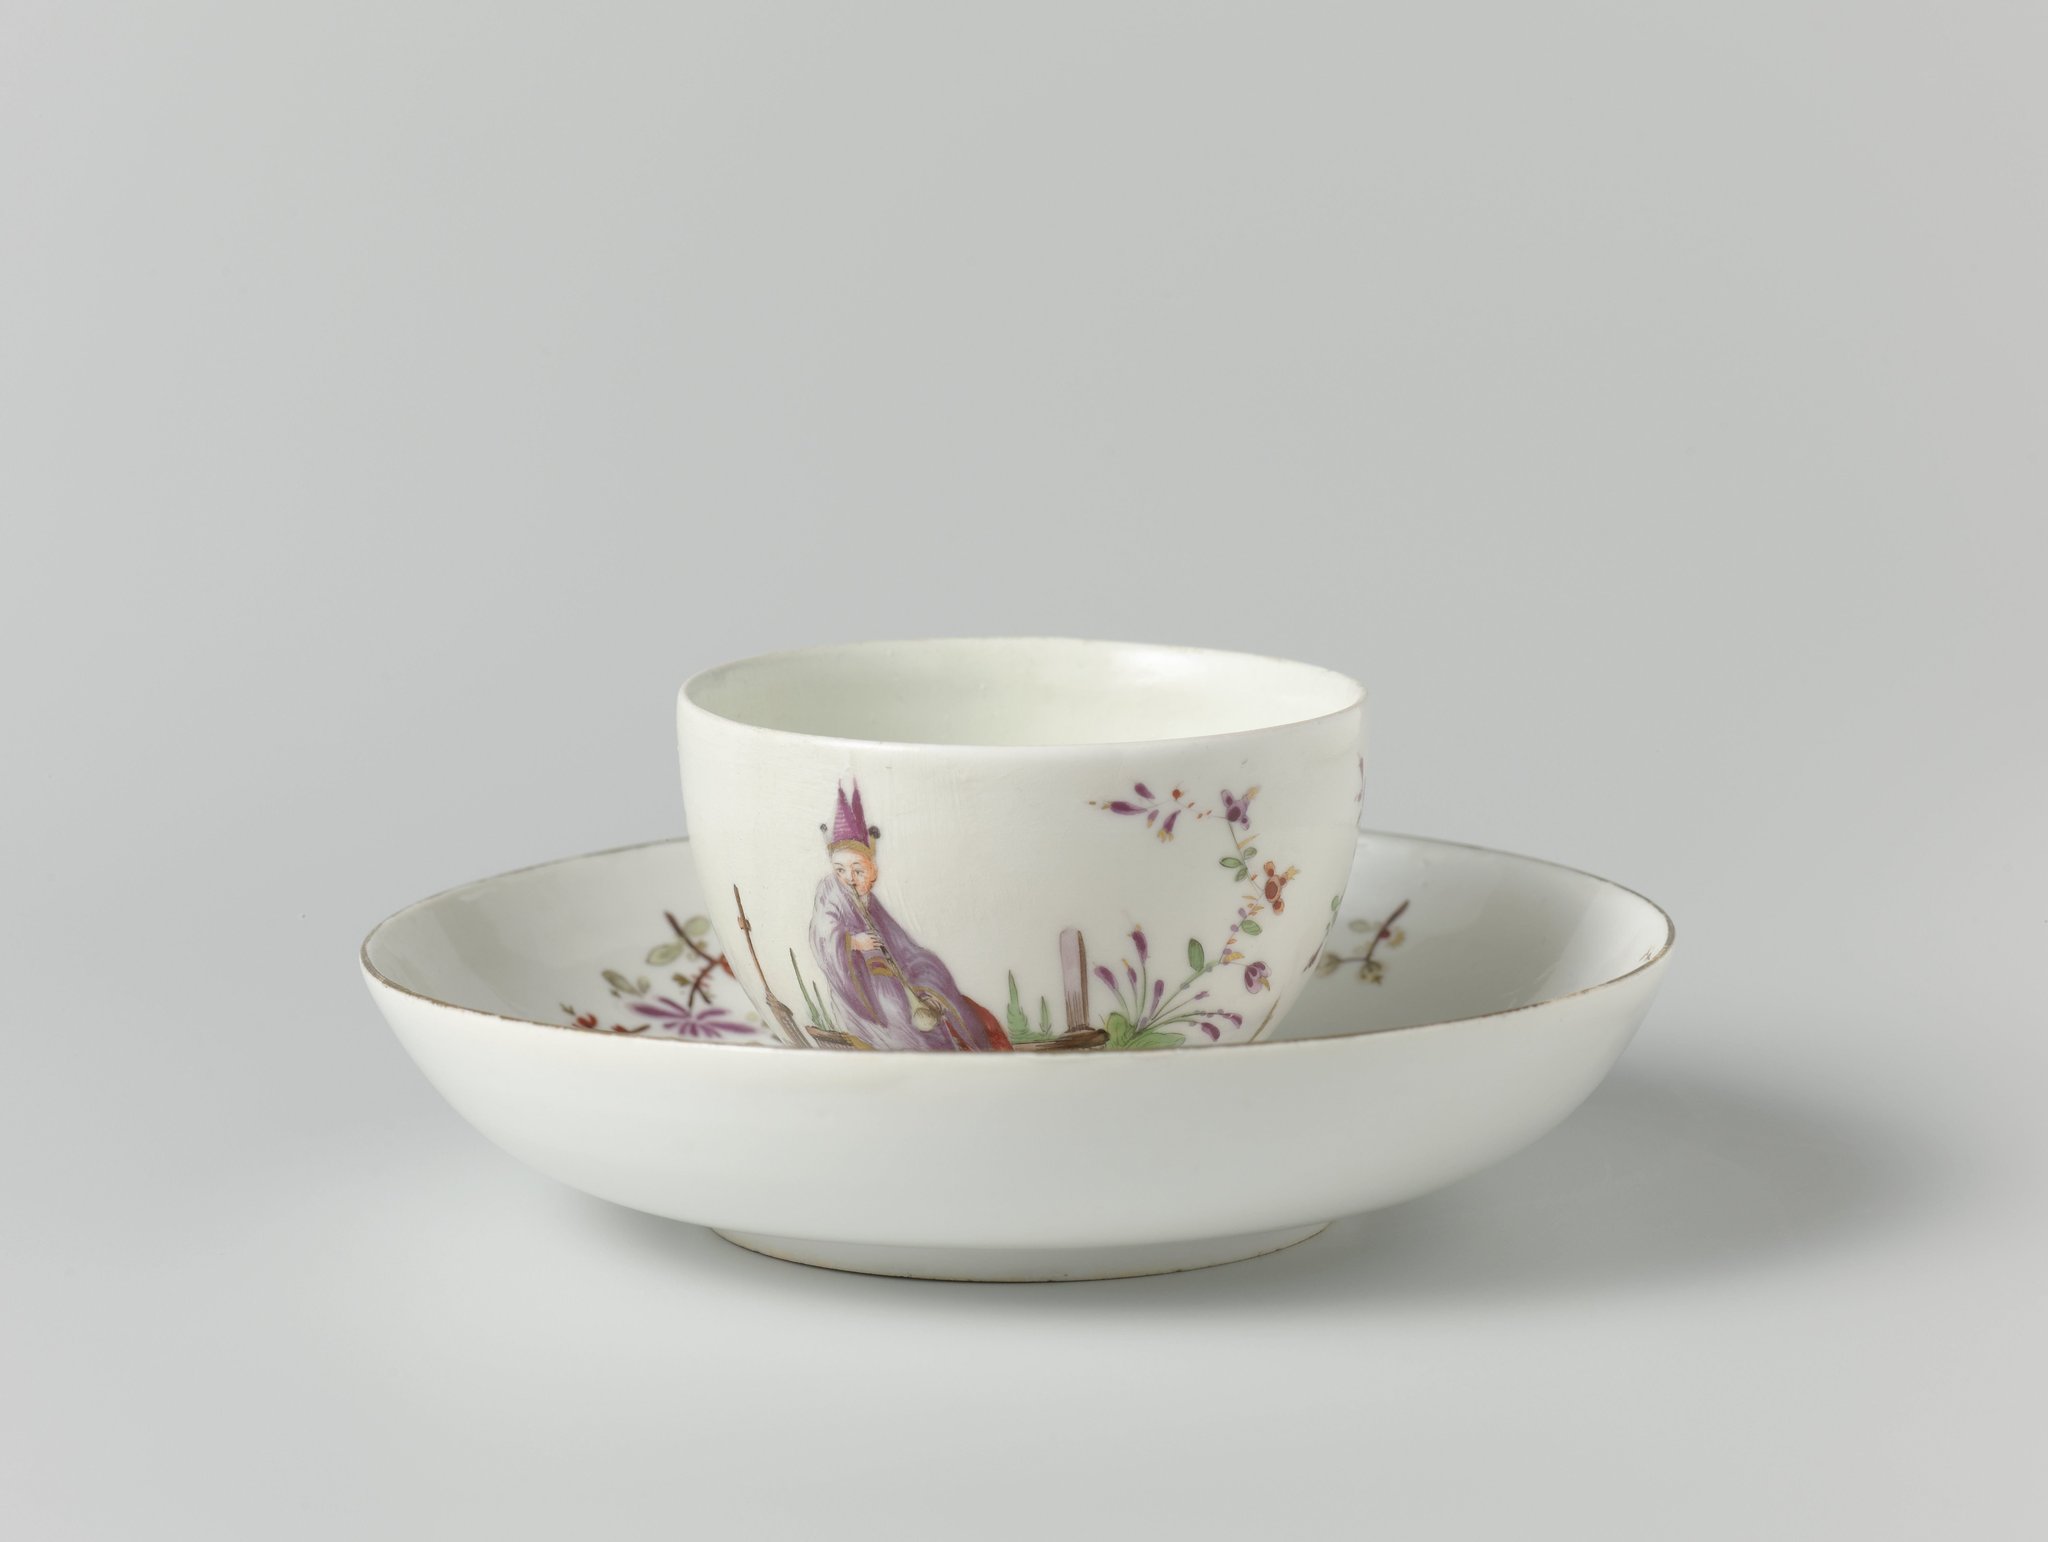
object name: kop en schotel, kop en schotel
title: Cup and saucer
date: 1765-1770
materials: porcelain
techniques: painted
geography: weesp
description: This cup and saucer are embellished with depictions of Chinese figures, a type of decoration called chinoiserie. The figure on the cup plays a wind instrument; the one on the saucer is situated in a landscape. Such decorations, combined with exotic flowers, were inspired by the painted decoration found on porcelain at Meissen from about 1725.